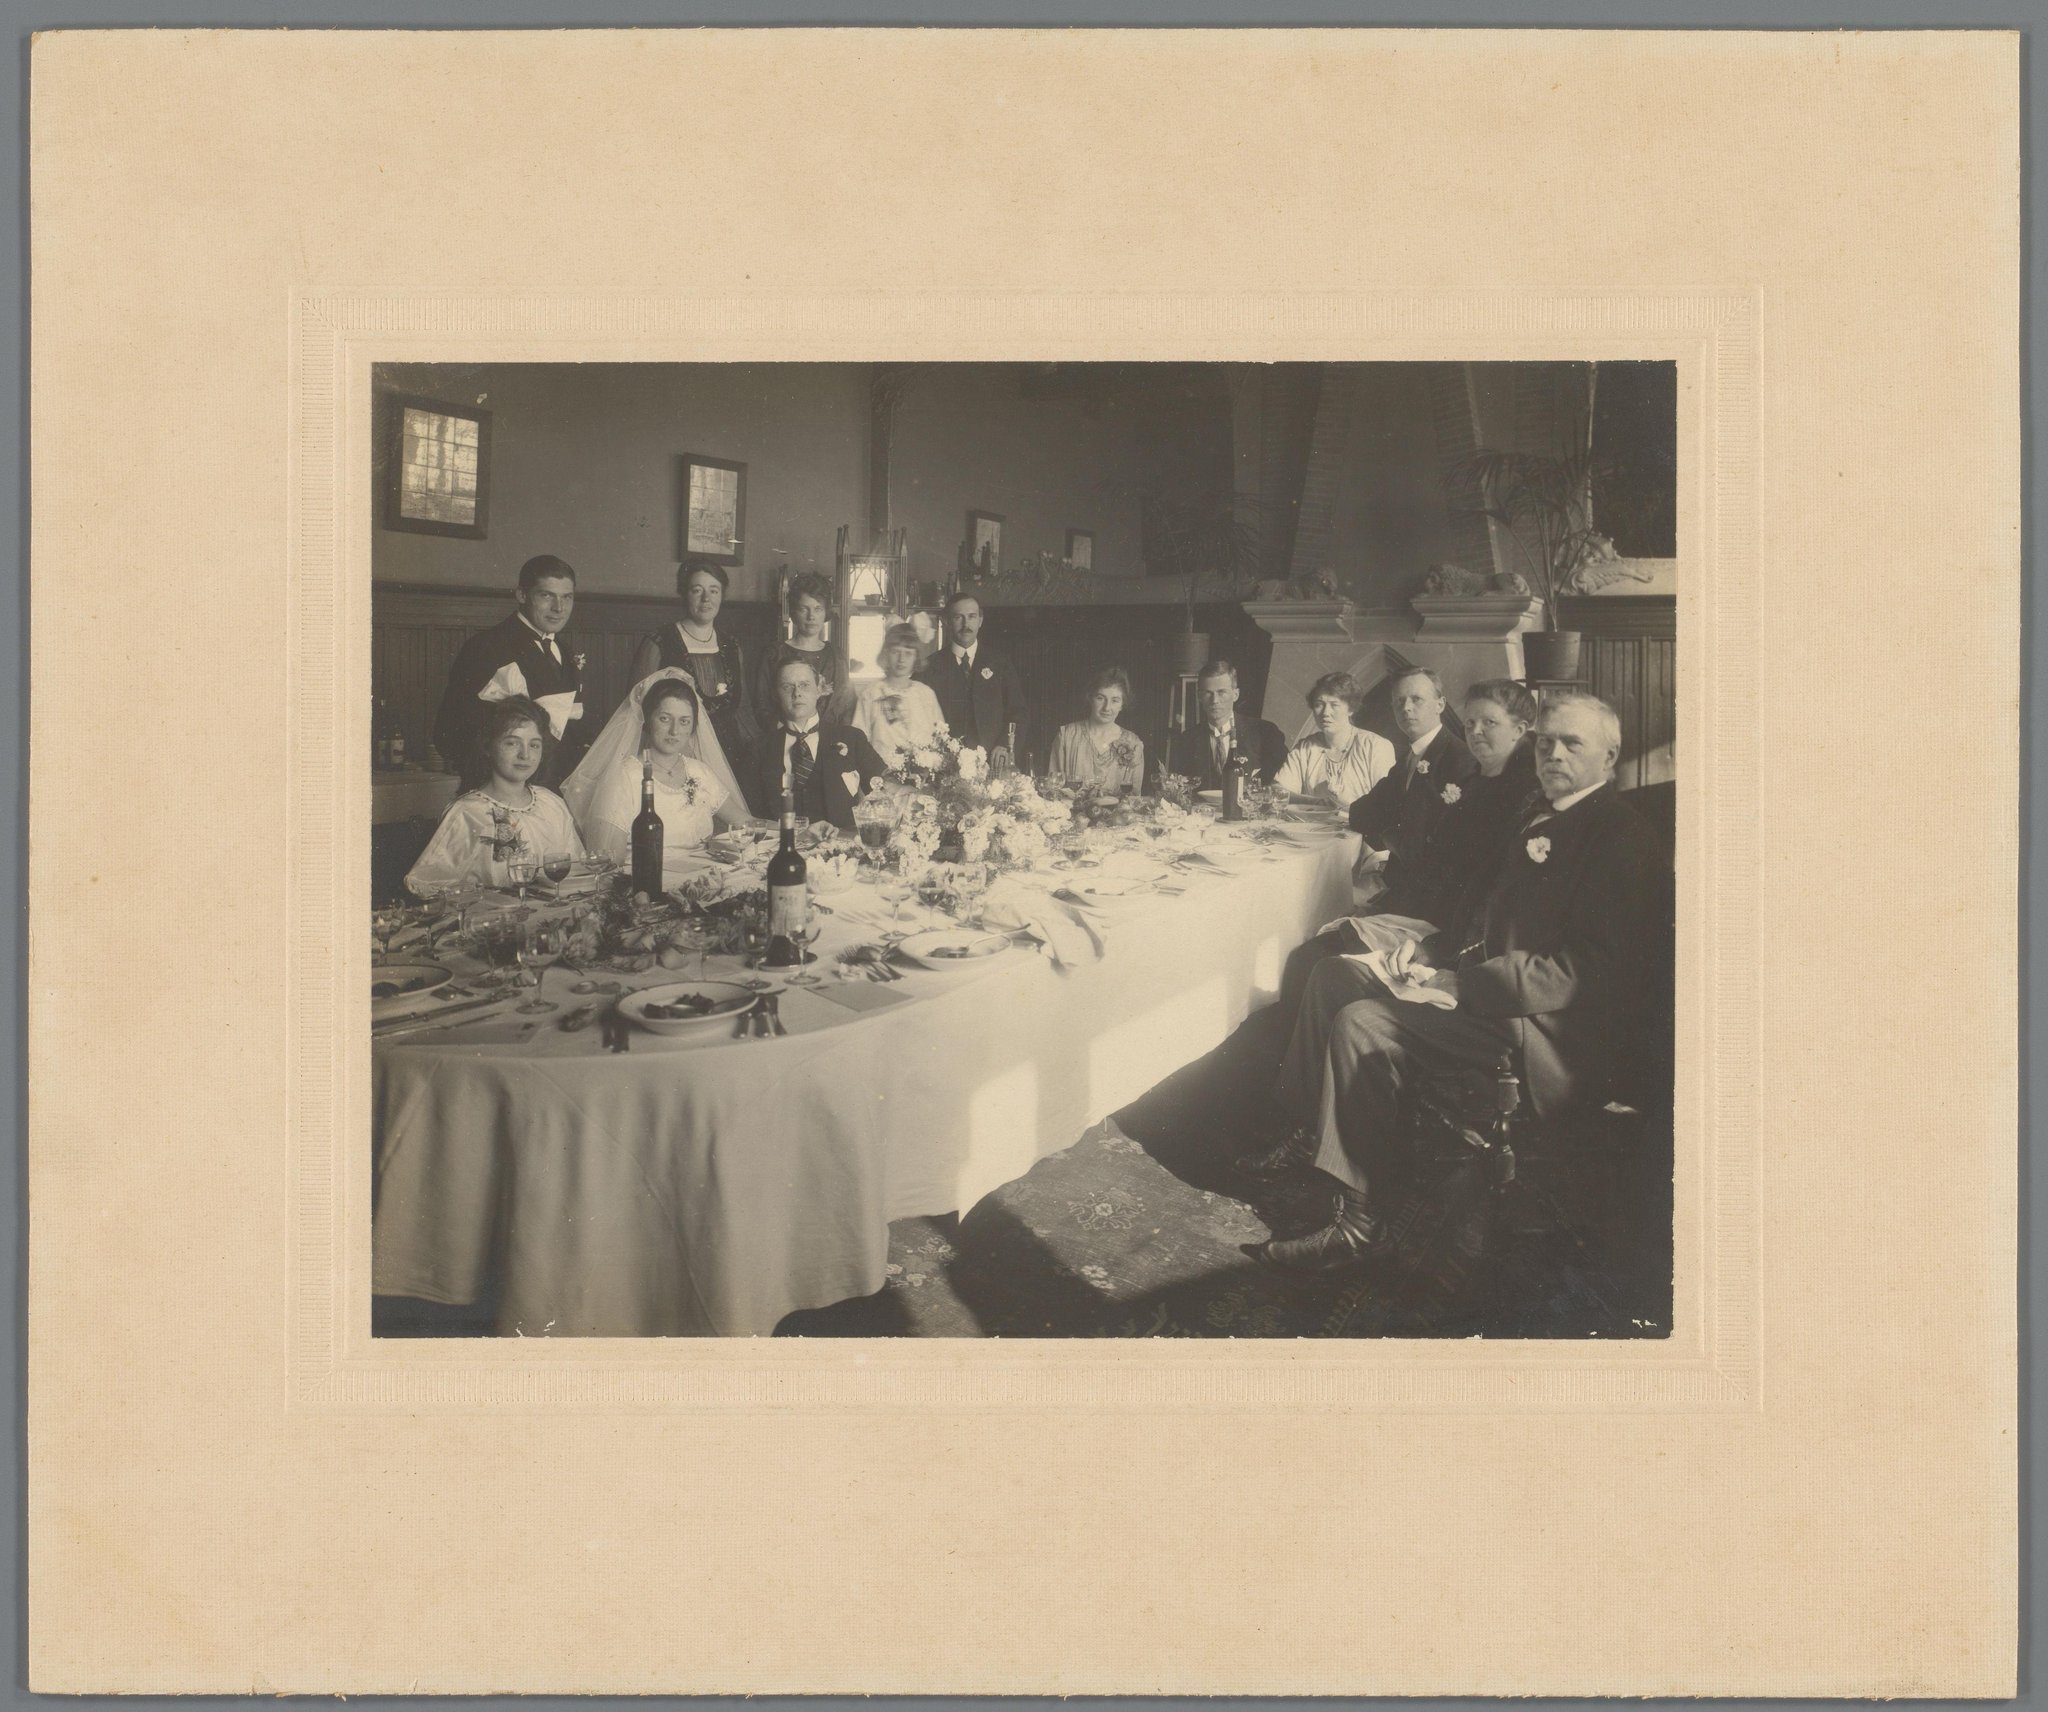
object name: photograph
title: Groepsportret van de familie Jonker bij een bruiloftsmaal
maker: Anonymous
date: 1915-1925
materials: paper, cardboard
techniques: gelatin silver print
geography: netherlands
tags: wedding feast, wedding meal, family group, especially parents with their child(ren)